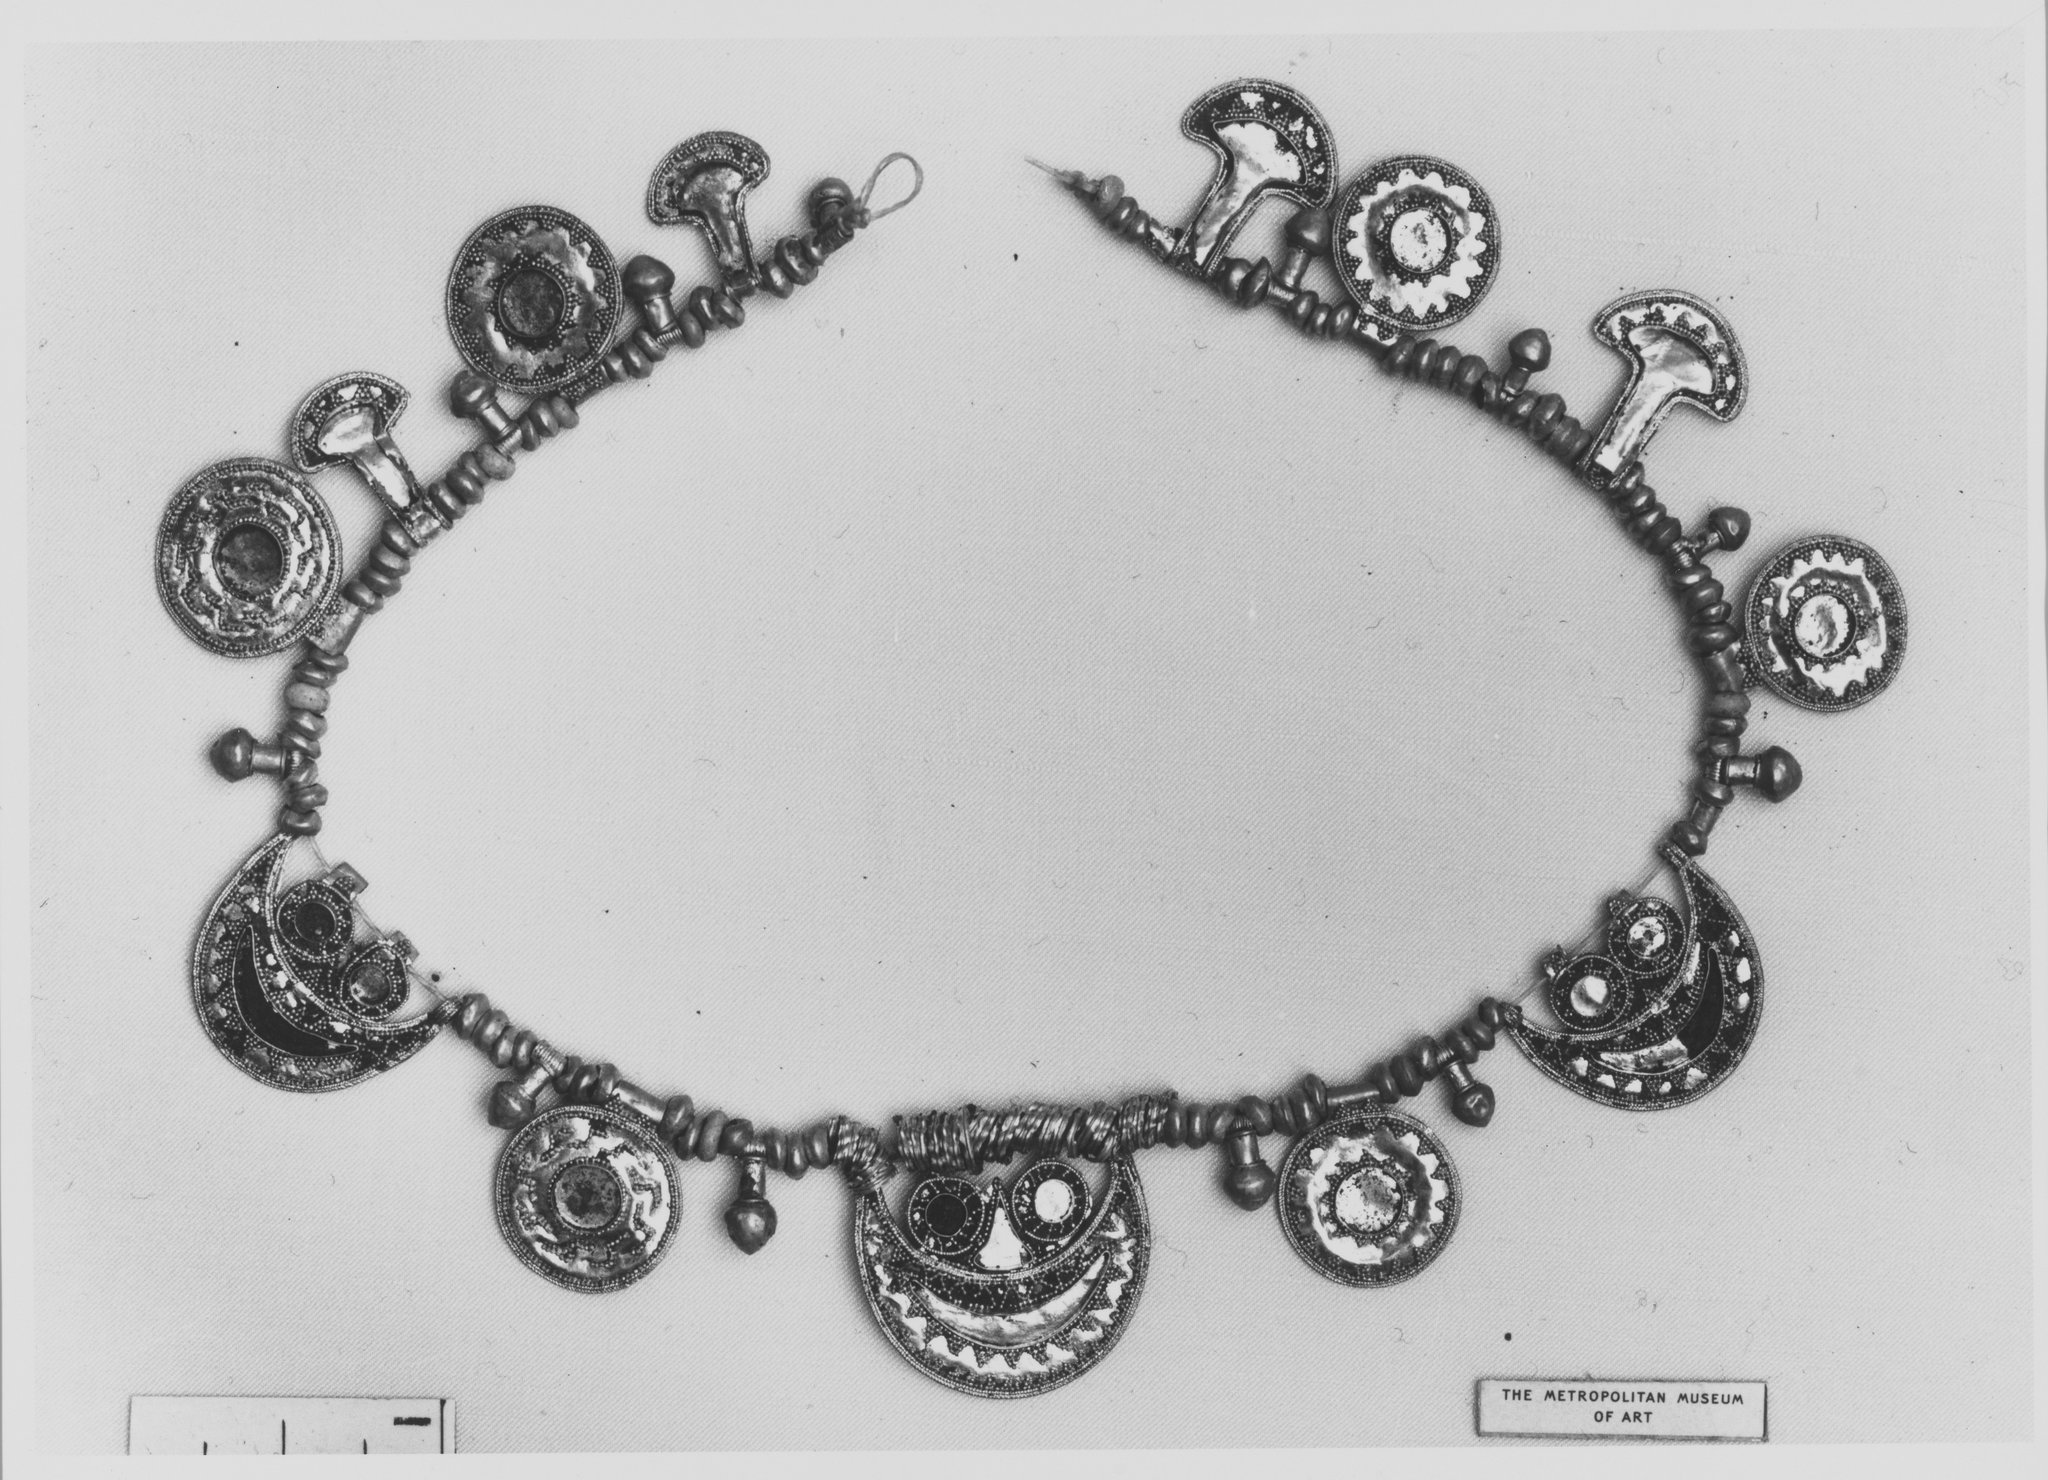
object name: necklace with pendant, bead, amber inlay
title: Gold necklace with inlaid amber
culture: etrusco-phoenician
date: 700-601 BCE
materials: amber, gold